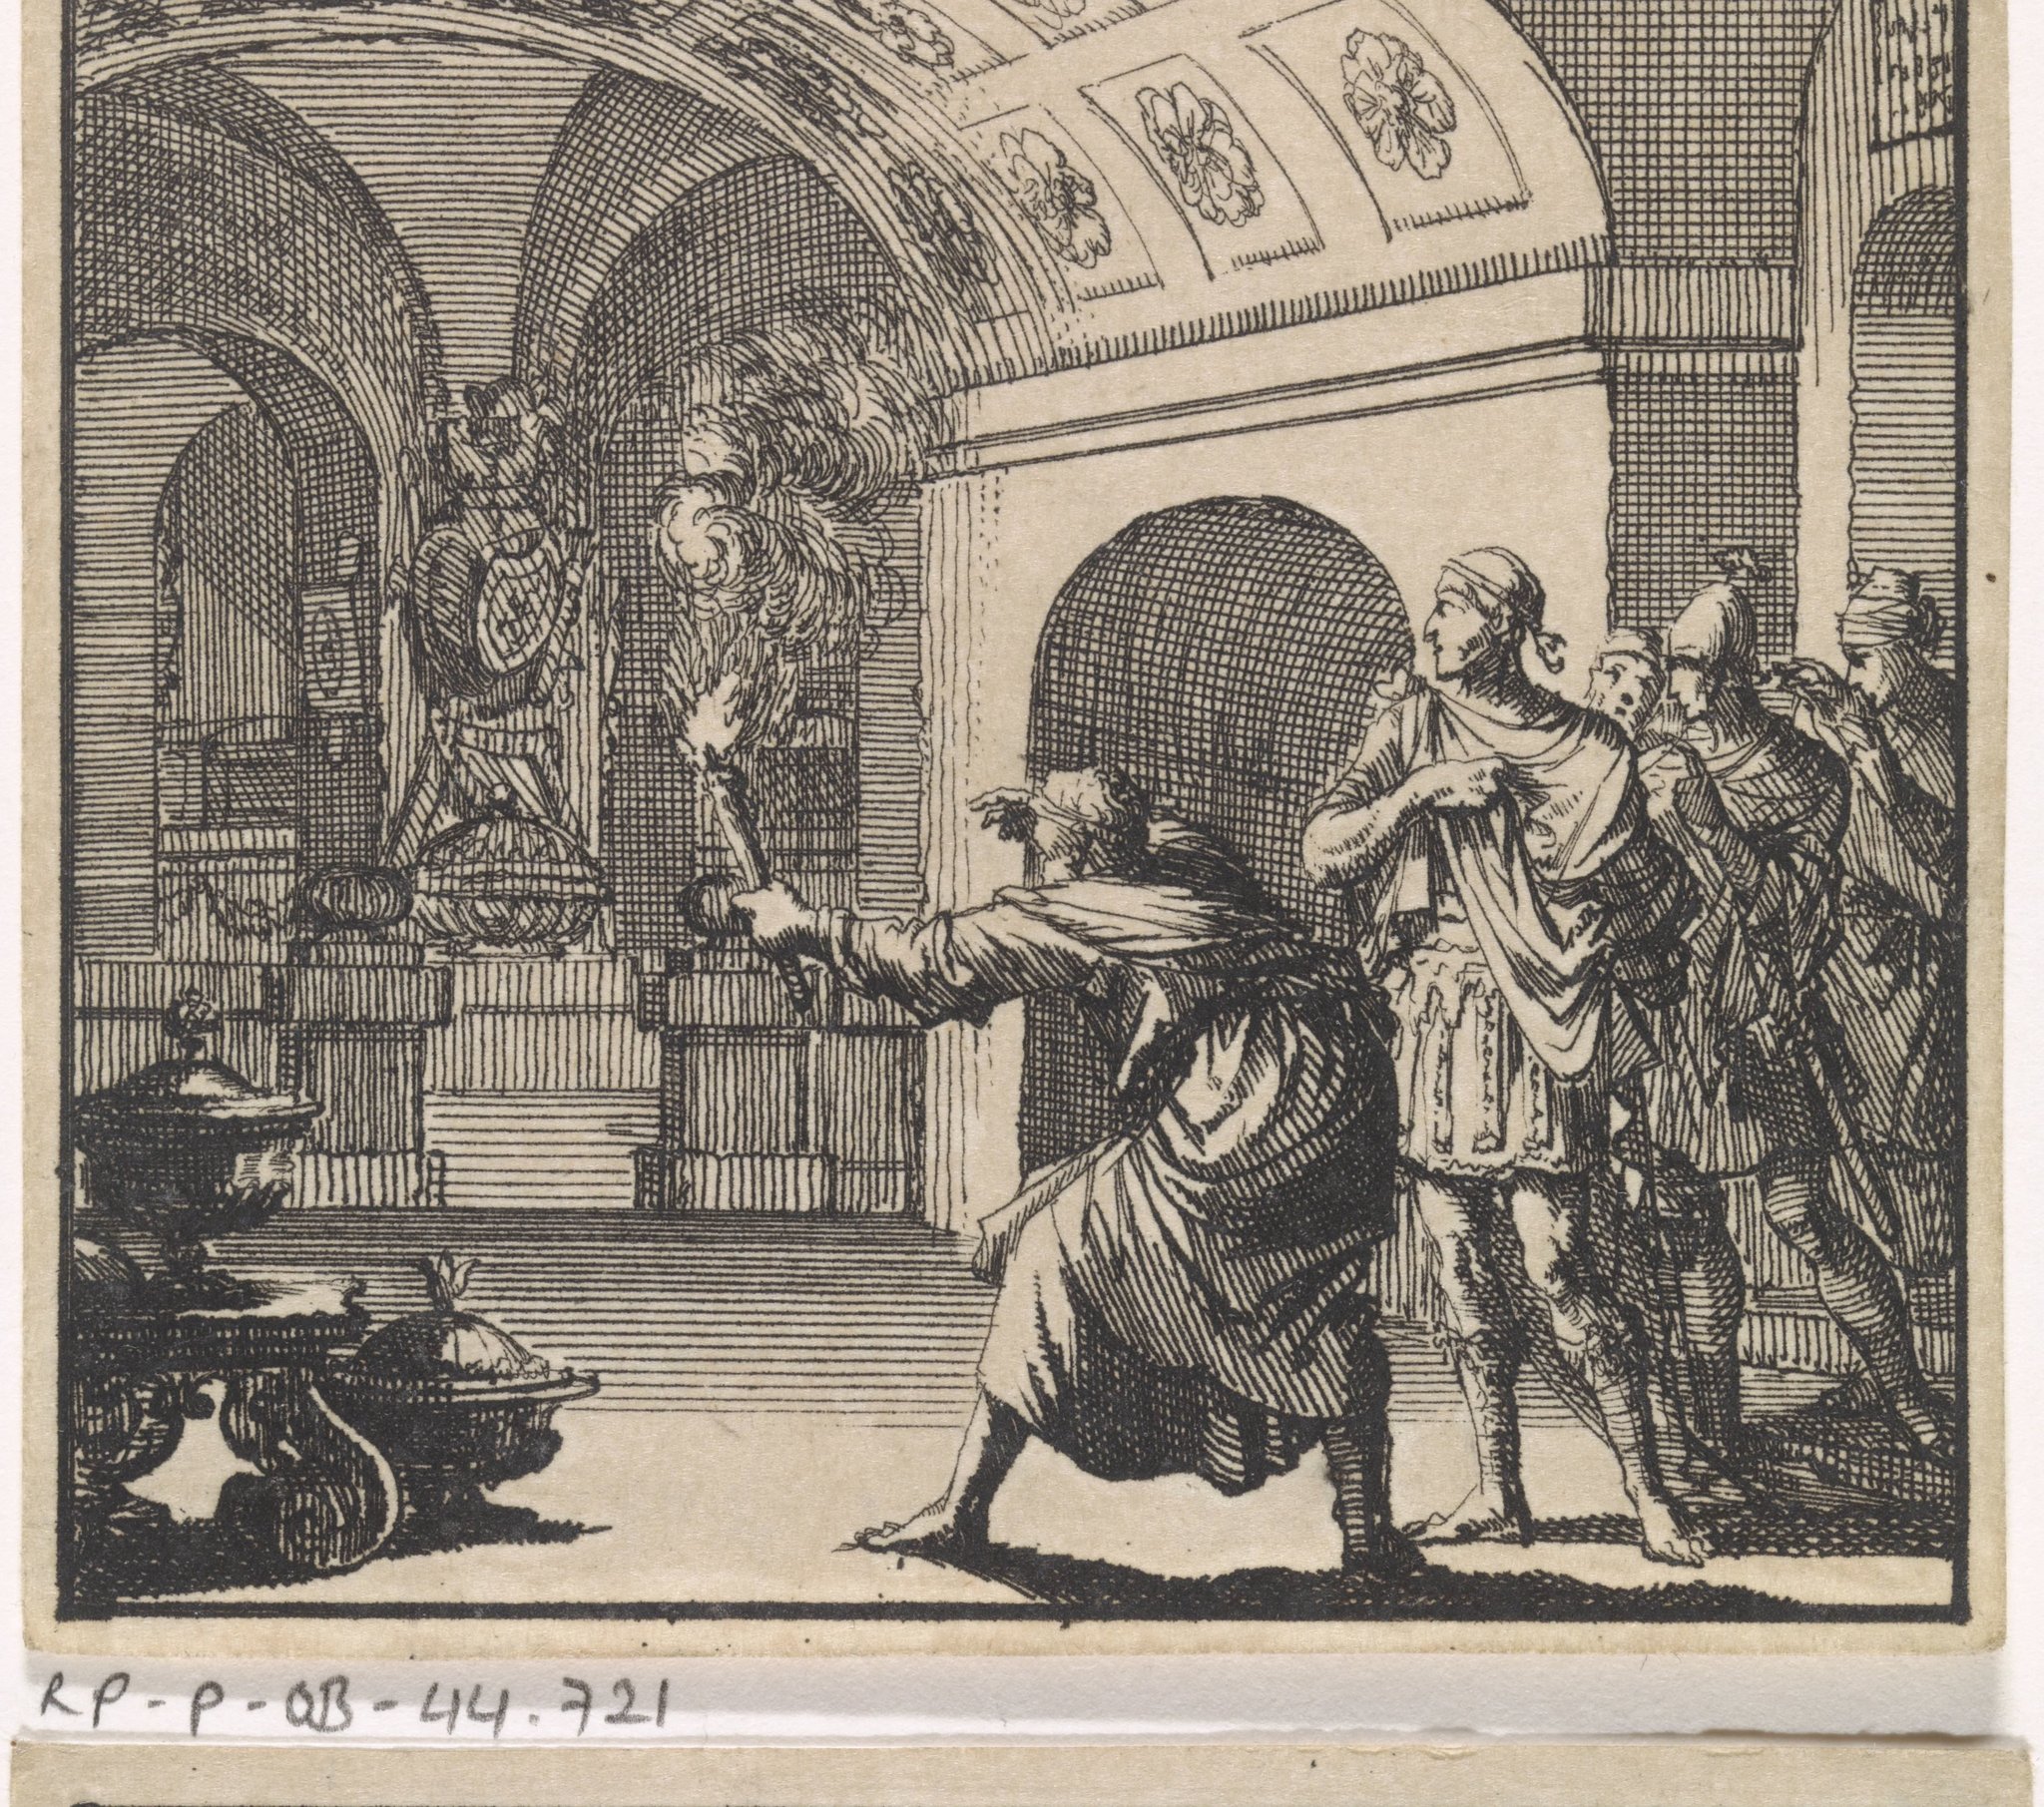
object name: print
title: Herodes in David's graf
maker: jan luyken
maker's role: draughtsman, print maker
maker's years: 1649-1712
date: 1698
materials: paper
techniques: etching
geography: amsterdam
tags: david's grave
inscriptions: collector's mark: Lugt 2228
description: Proefdruk van illustratie uit: Josephus, Flavius. XX. boeken van de oude geschiedenissen der joden, 4 delen. Amsterdam: Barent Visscher, Willem de Coup, Willem van Lamsveld, Andries van Damme, 1698, dl. II.